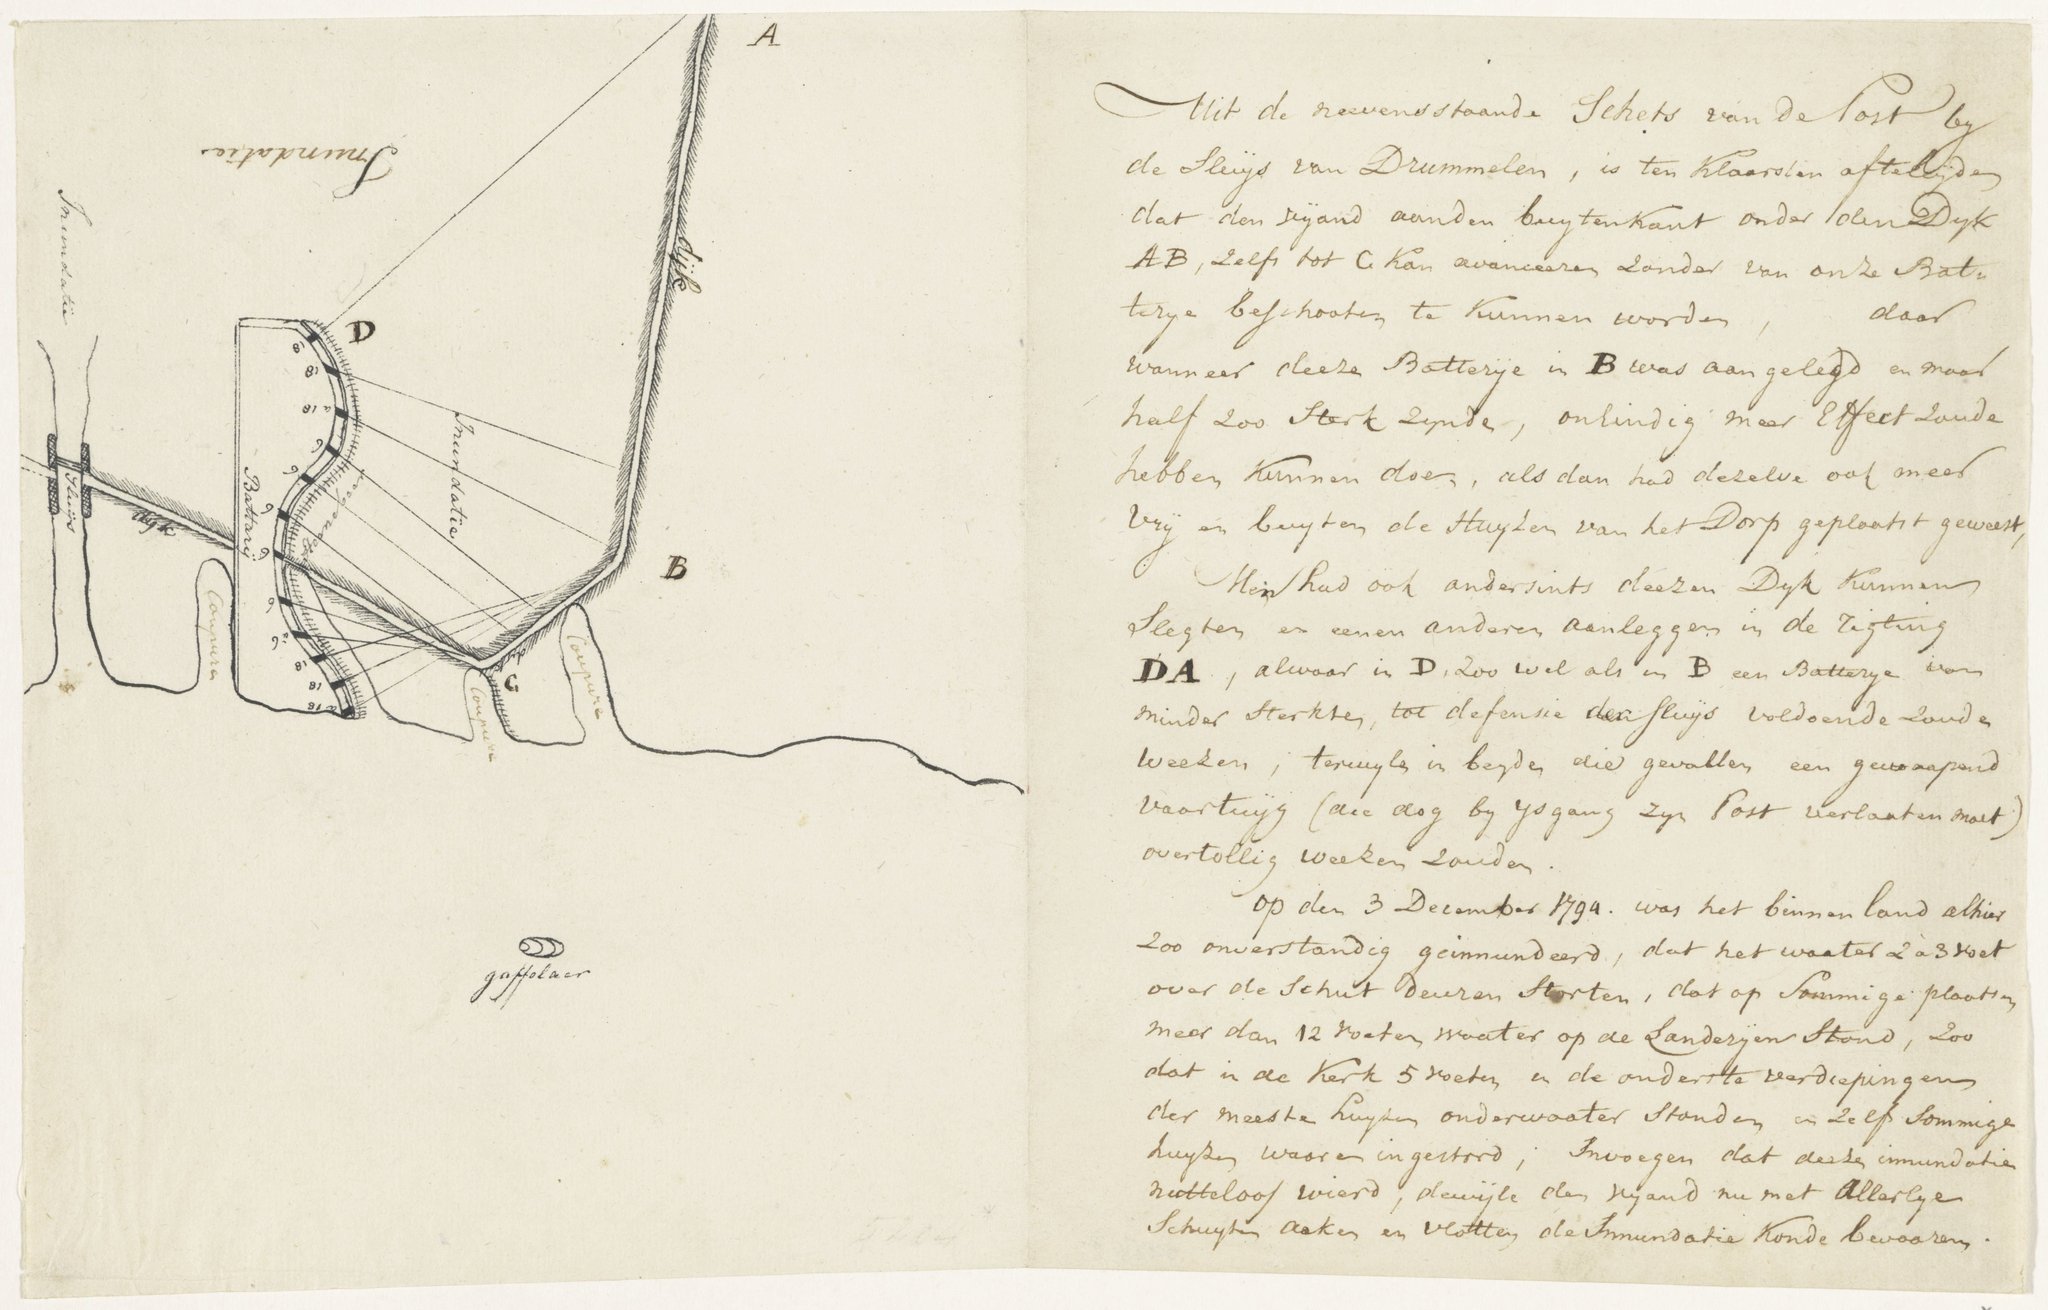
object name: drawing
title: Inundatie bij de sluis van Drimmelen, 1794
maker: Anonymous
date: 1794-1795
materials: paper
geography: northern netherlands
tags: dike-break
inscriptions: collector's mark: Lugt 2228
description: Schets van de inundatie van het land in de omgeving van de sluis van Drimmelen, tegen de oprukkende Franse troepen, op 3 december 1794. Links een schets van een plattegrond met de sluis en de dijk met de batterij, rechts handschrift met een beschrijving van de situatie.